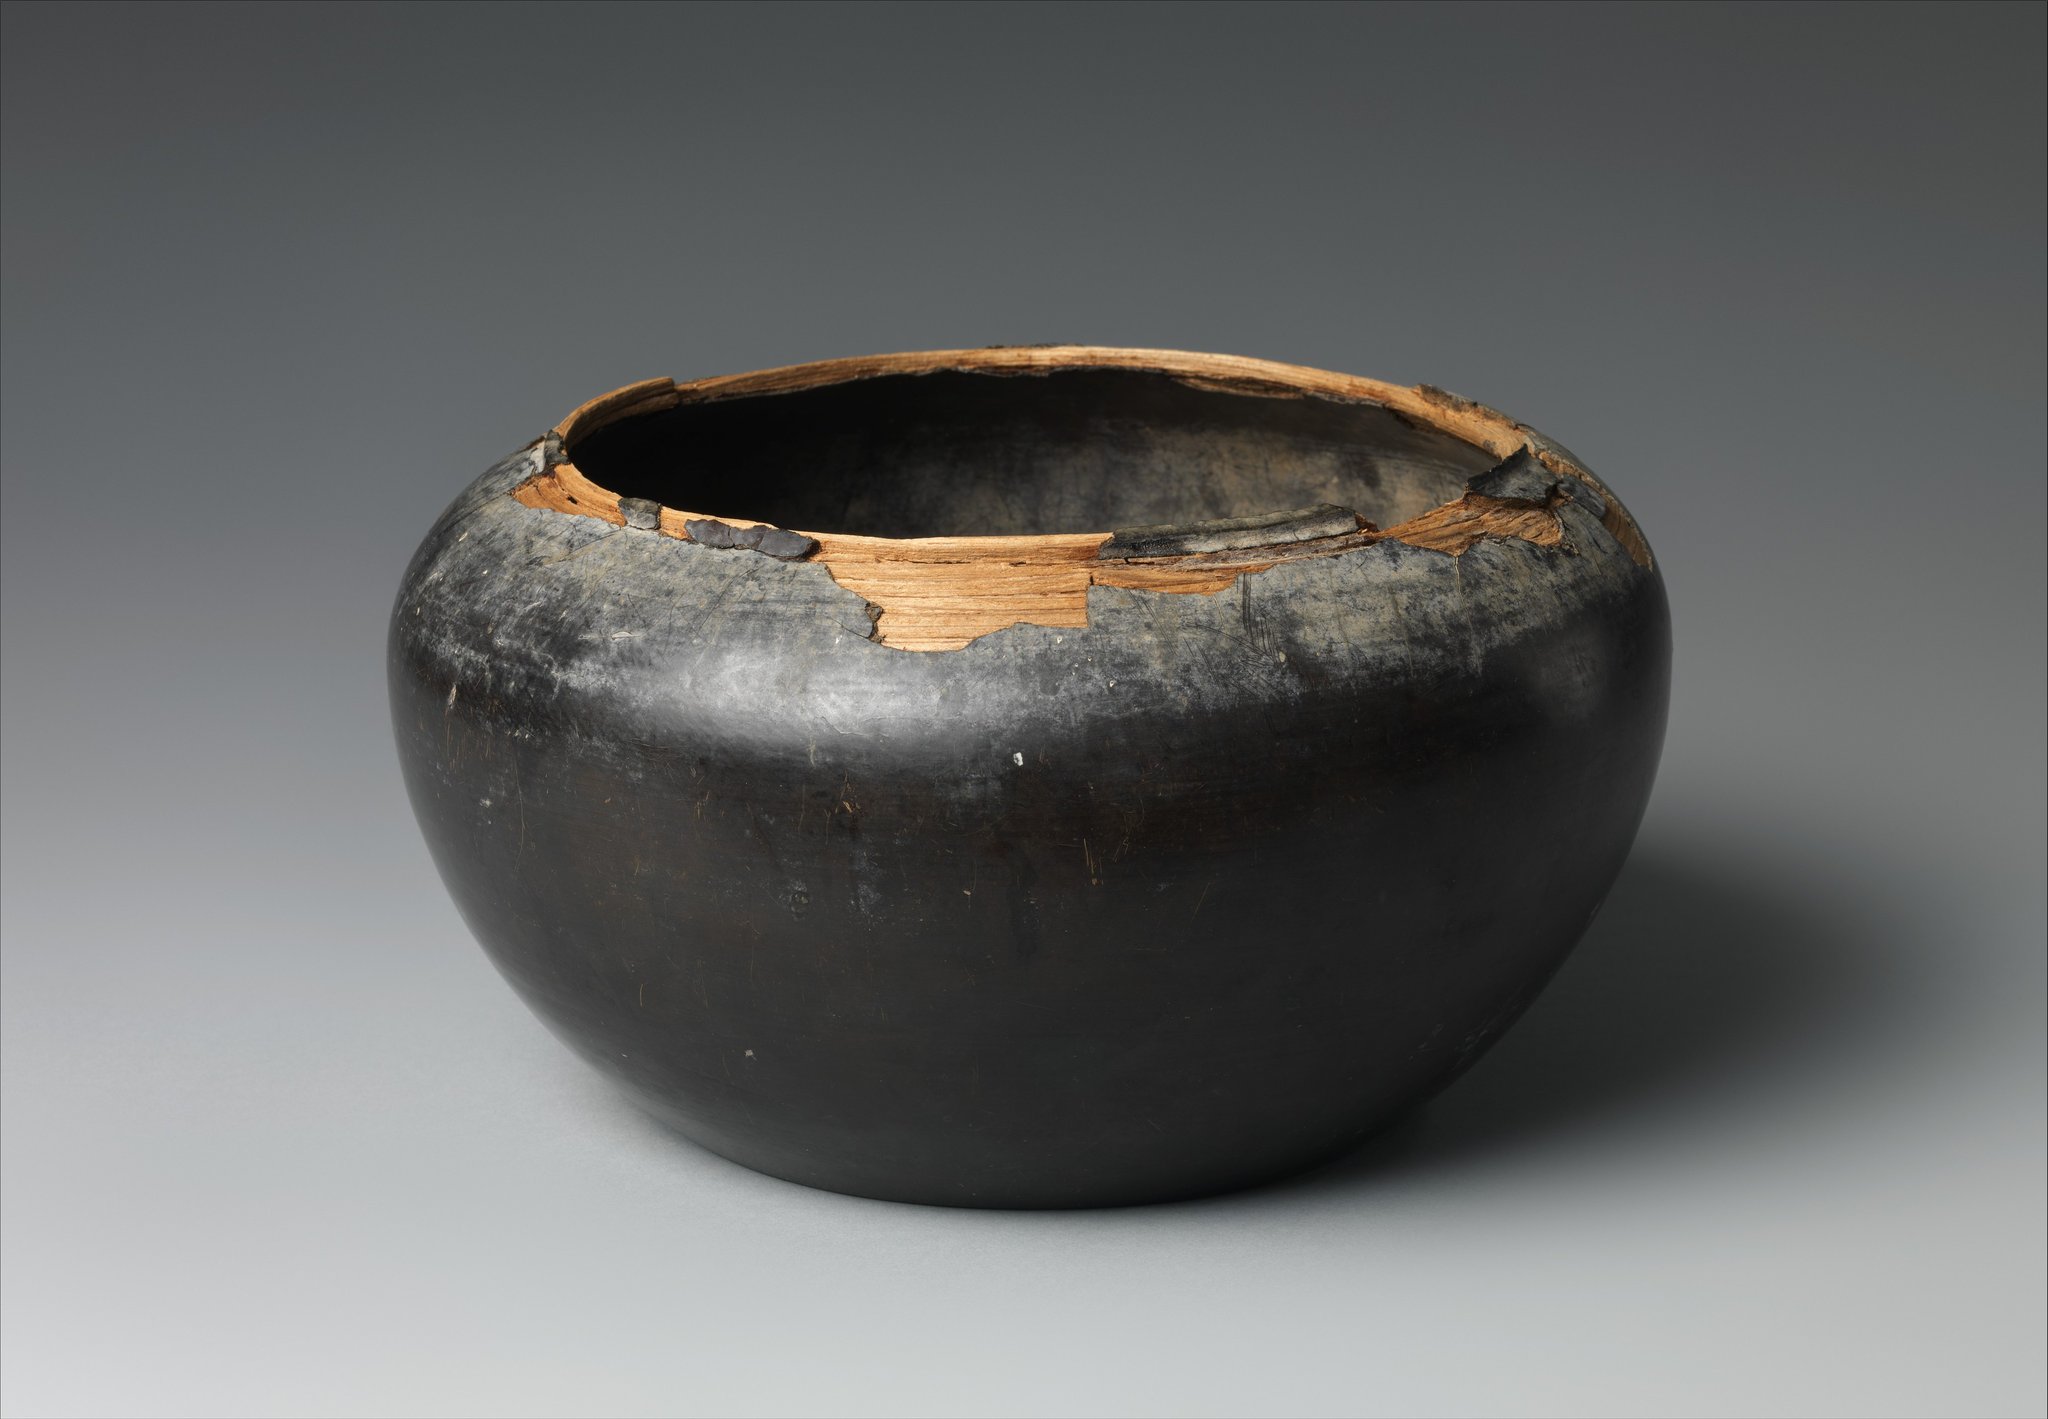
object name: bowl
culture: chinese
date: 801-1000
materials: lacquer, wood